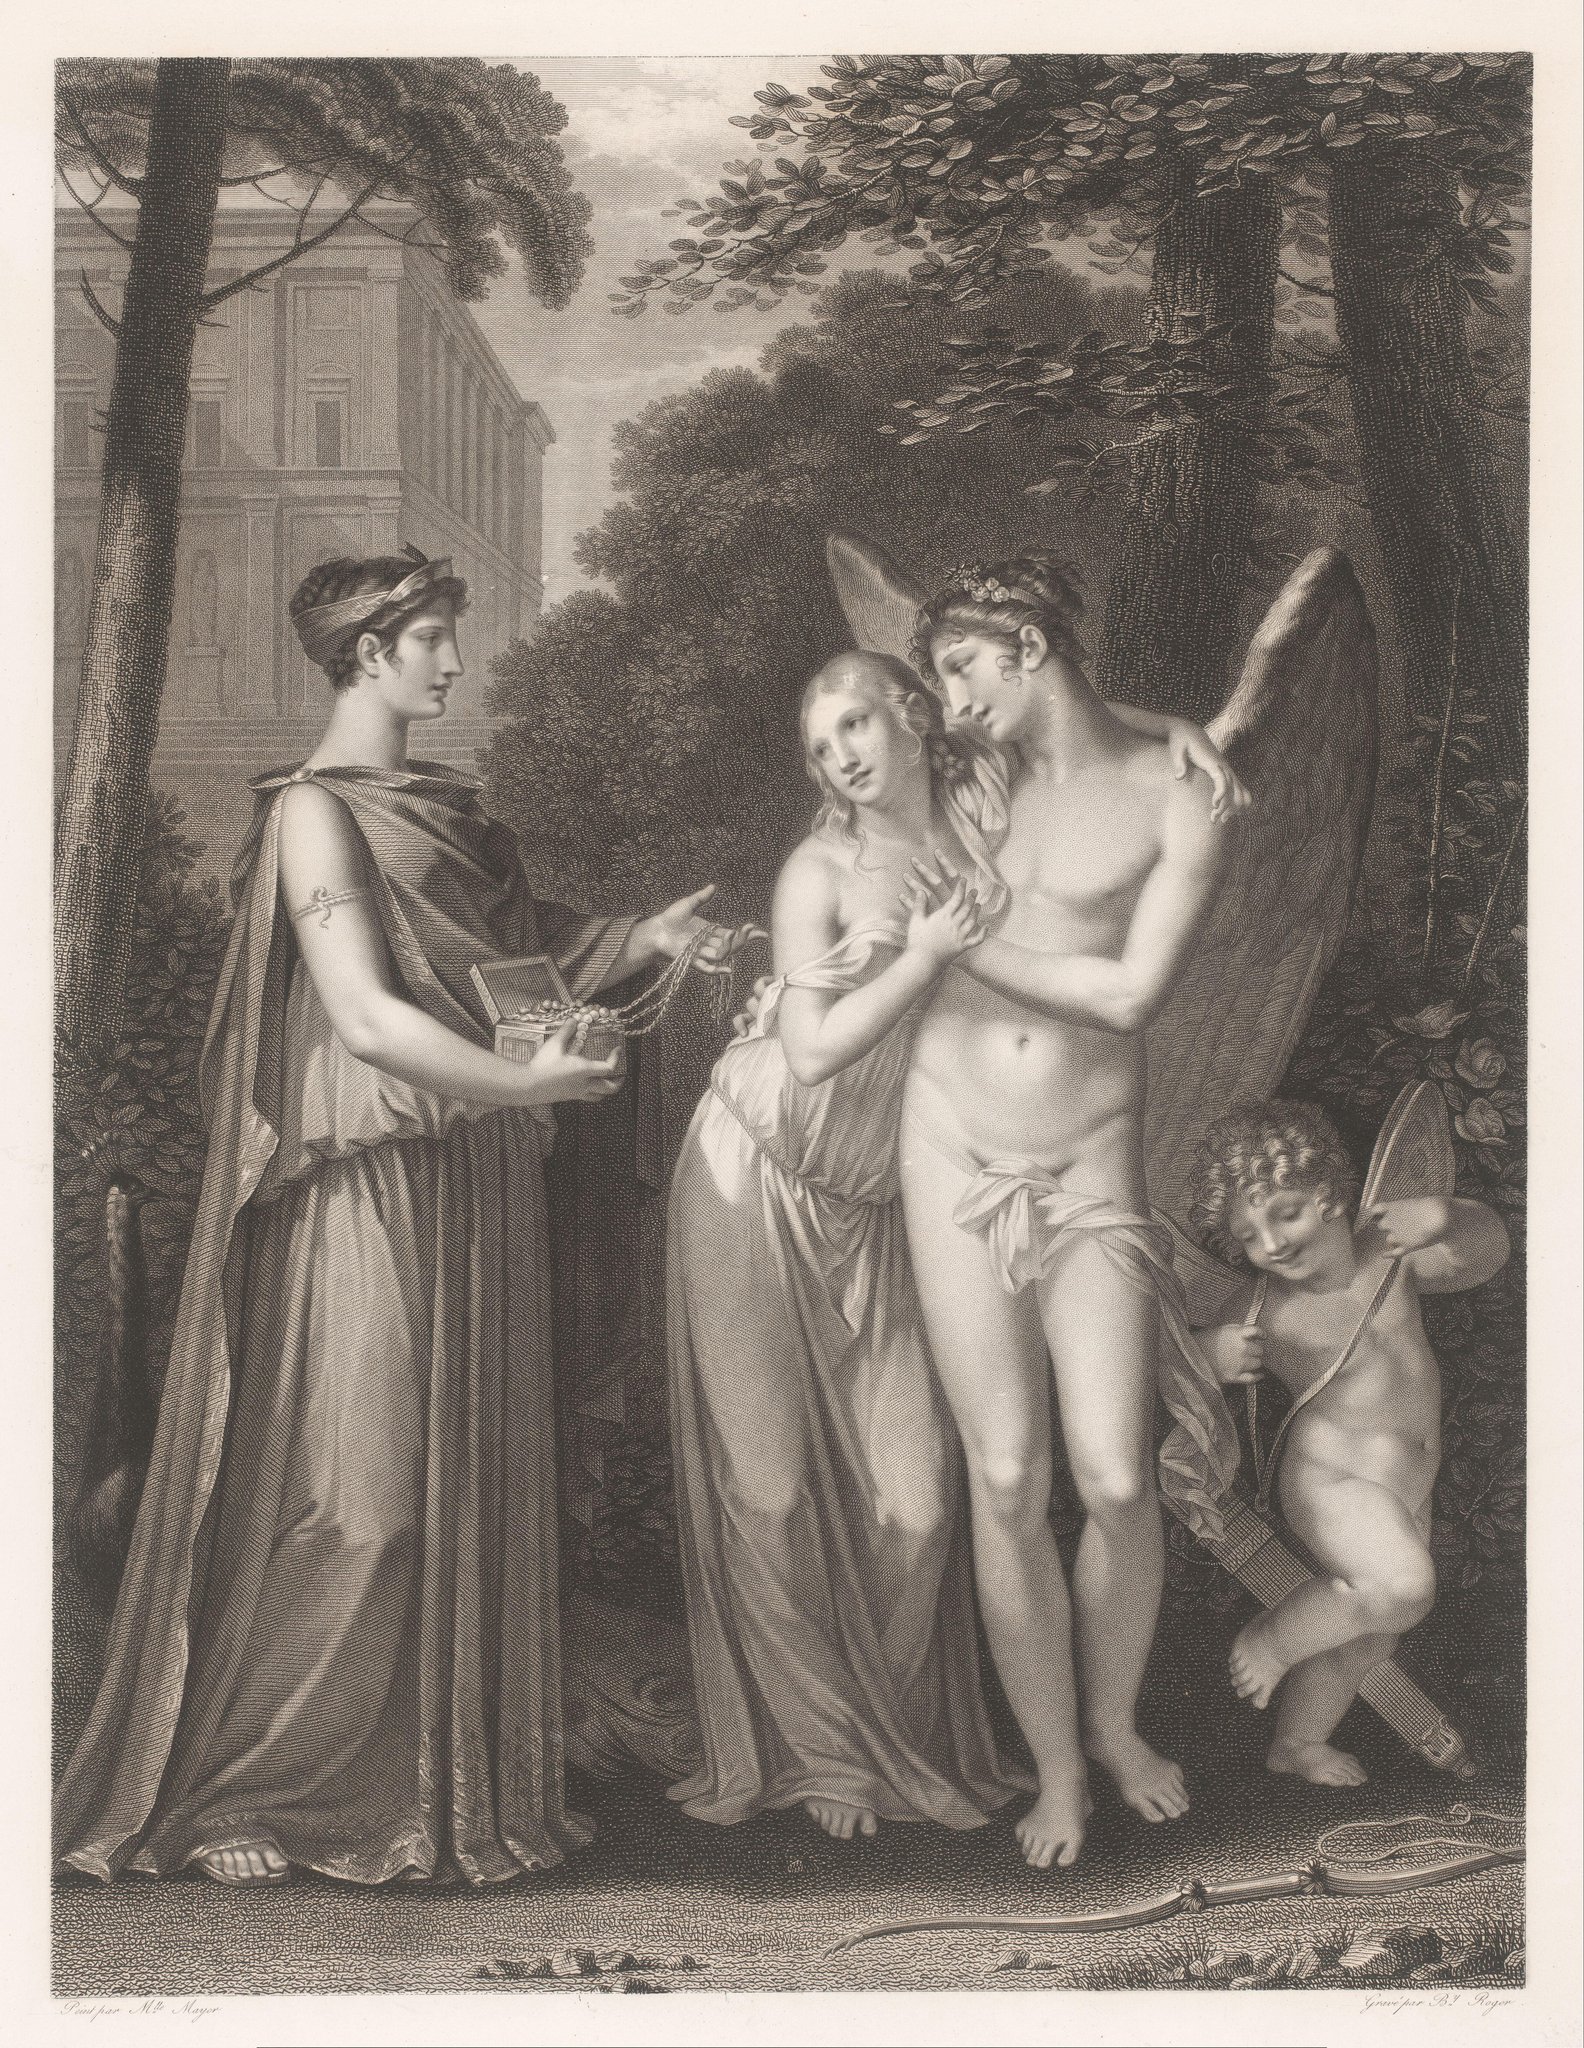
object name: print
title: L'Innocence préfère l'Amour à la Richesse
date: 1810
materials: paper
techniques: etching, roulette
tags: wealth, opulence; 'opulenza', 'richezza' (ripa), innocence; 'innocenza', 'innocenza o purità' (ripa), (story of) cupid, amor (eros)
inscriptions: collector's mark: Lugt 2228, collector's mark: Lugt 2760